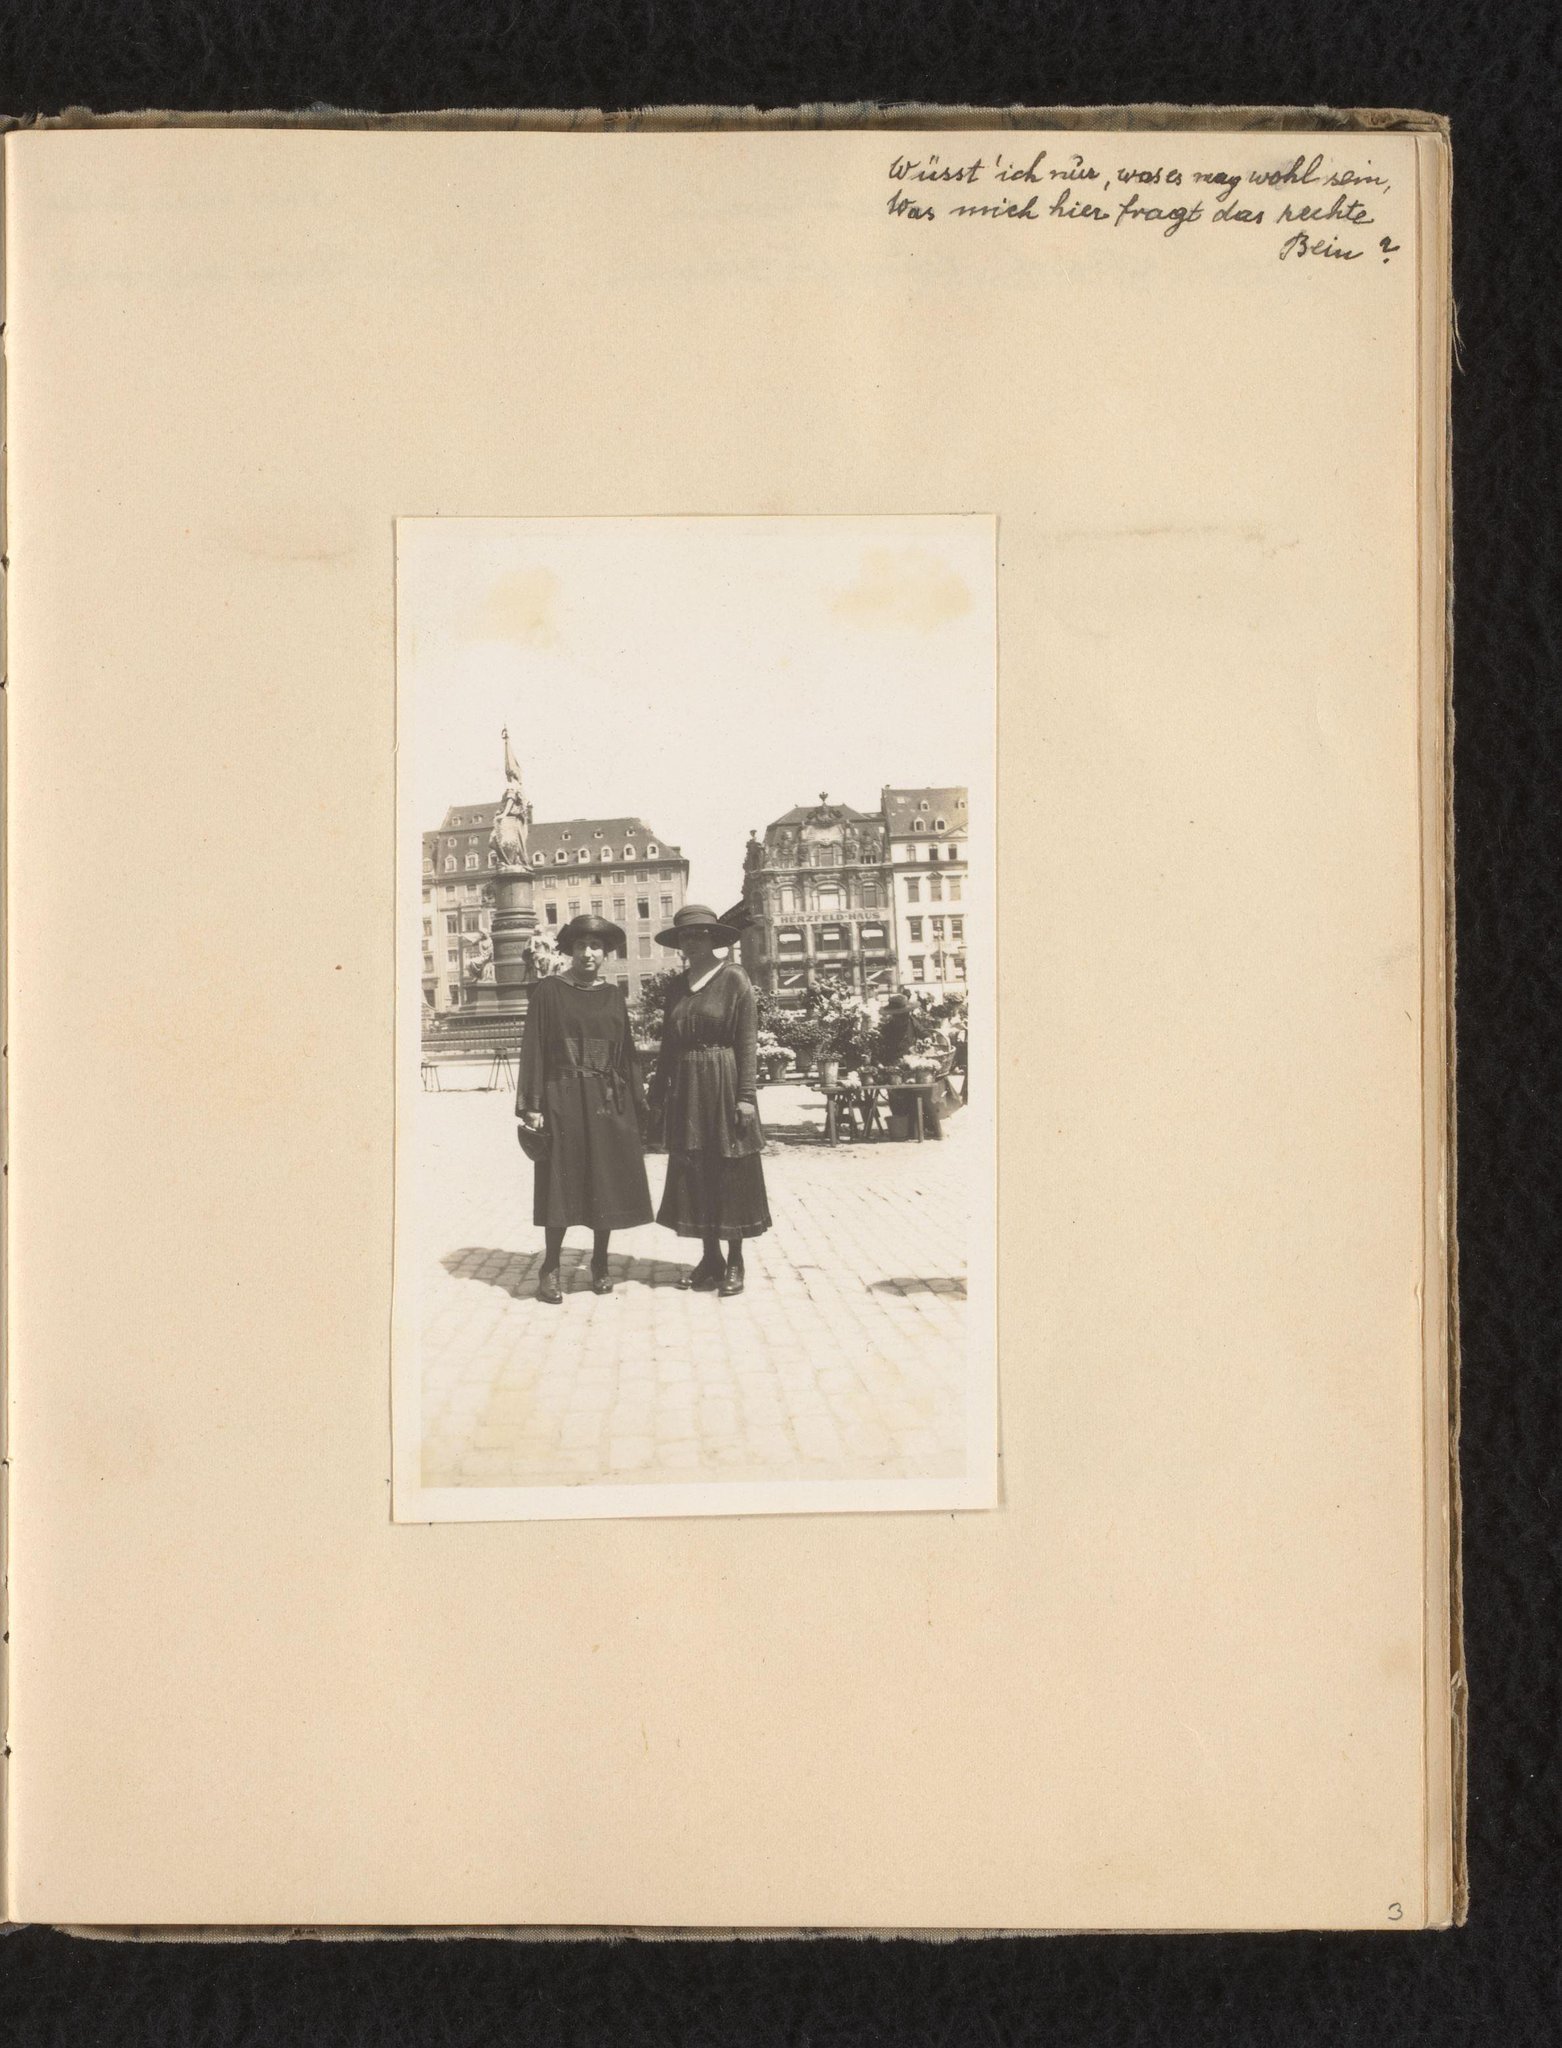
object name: photograph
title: Else Wachenheimer-Moos met een onbekende vrouw in de openlucht tijdens haar verlovingstijd, 1920-1922, Dresden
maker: else wachenheimer-moos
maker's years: 1895-1944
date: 1920-1922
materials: paper, photographic support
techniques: gelatin silver print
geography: dresden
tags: else wachenheimer-moos, the family travelling, on holiday, village square, place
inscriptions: inscription: ‘Wüsst ich nur, was es mag wohl sein//was mich hier fragt das rechte Bein?’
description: Blad bevat een foto van Else Wachenheimer-Moos (links) en onbekende vrouw (rechts). Onderdeel van het fotoalbum van de reizen die Eugen en Else Wachenheimer jaarlijks maakten rondom de viering van hun huwelijksdag en verloving.